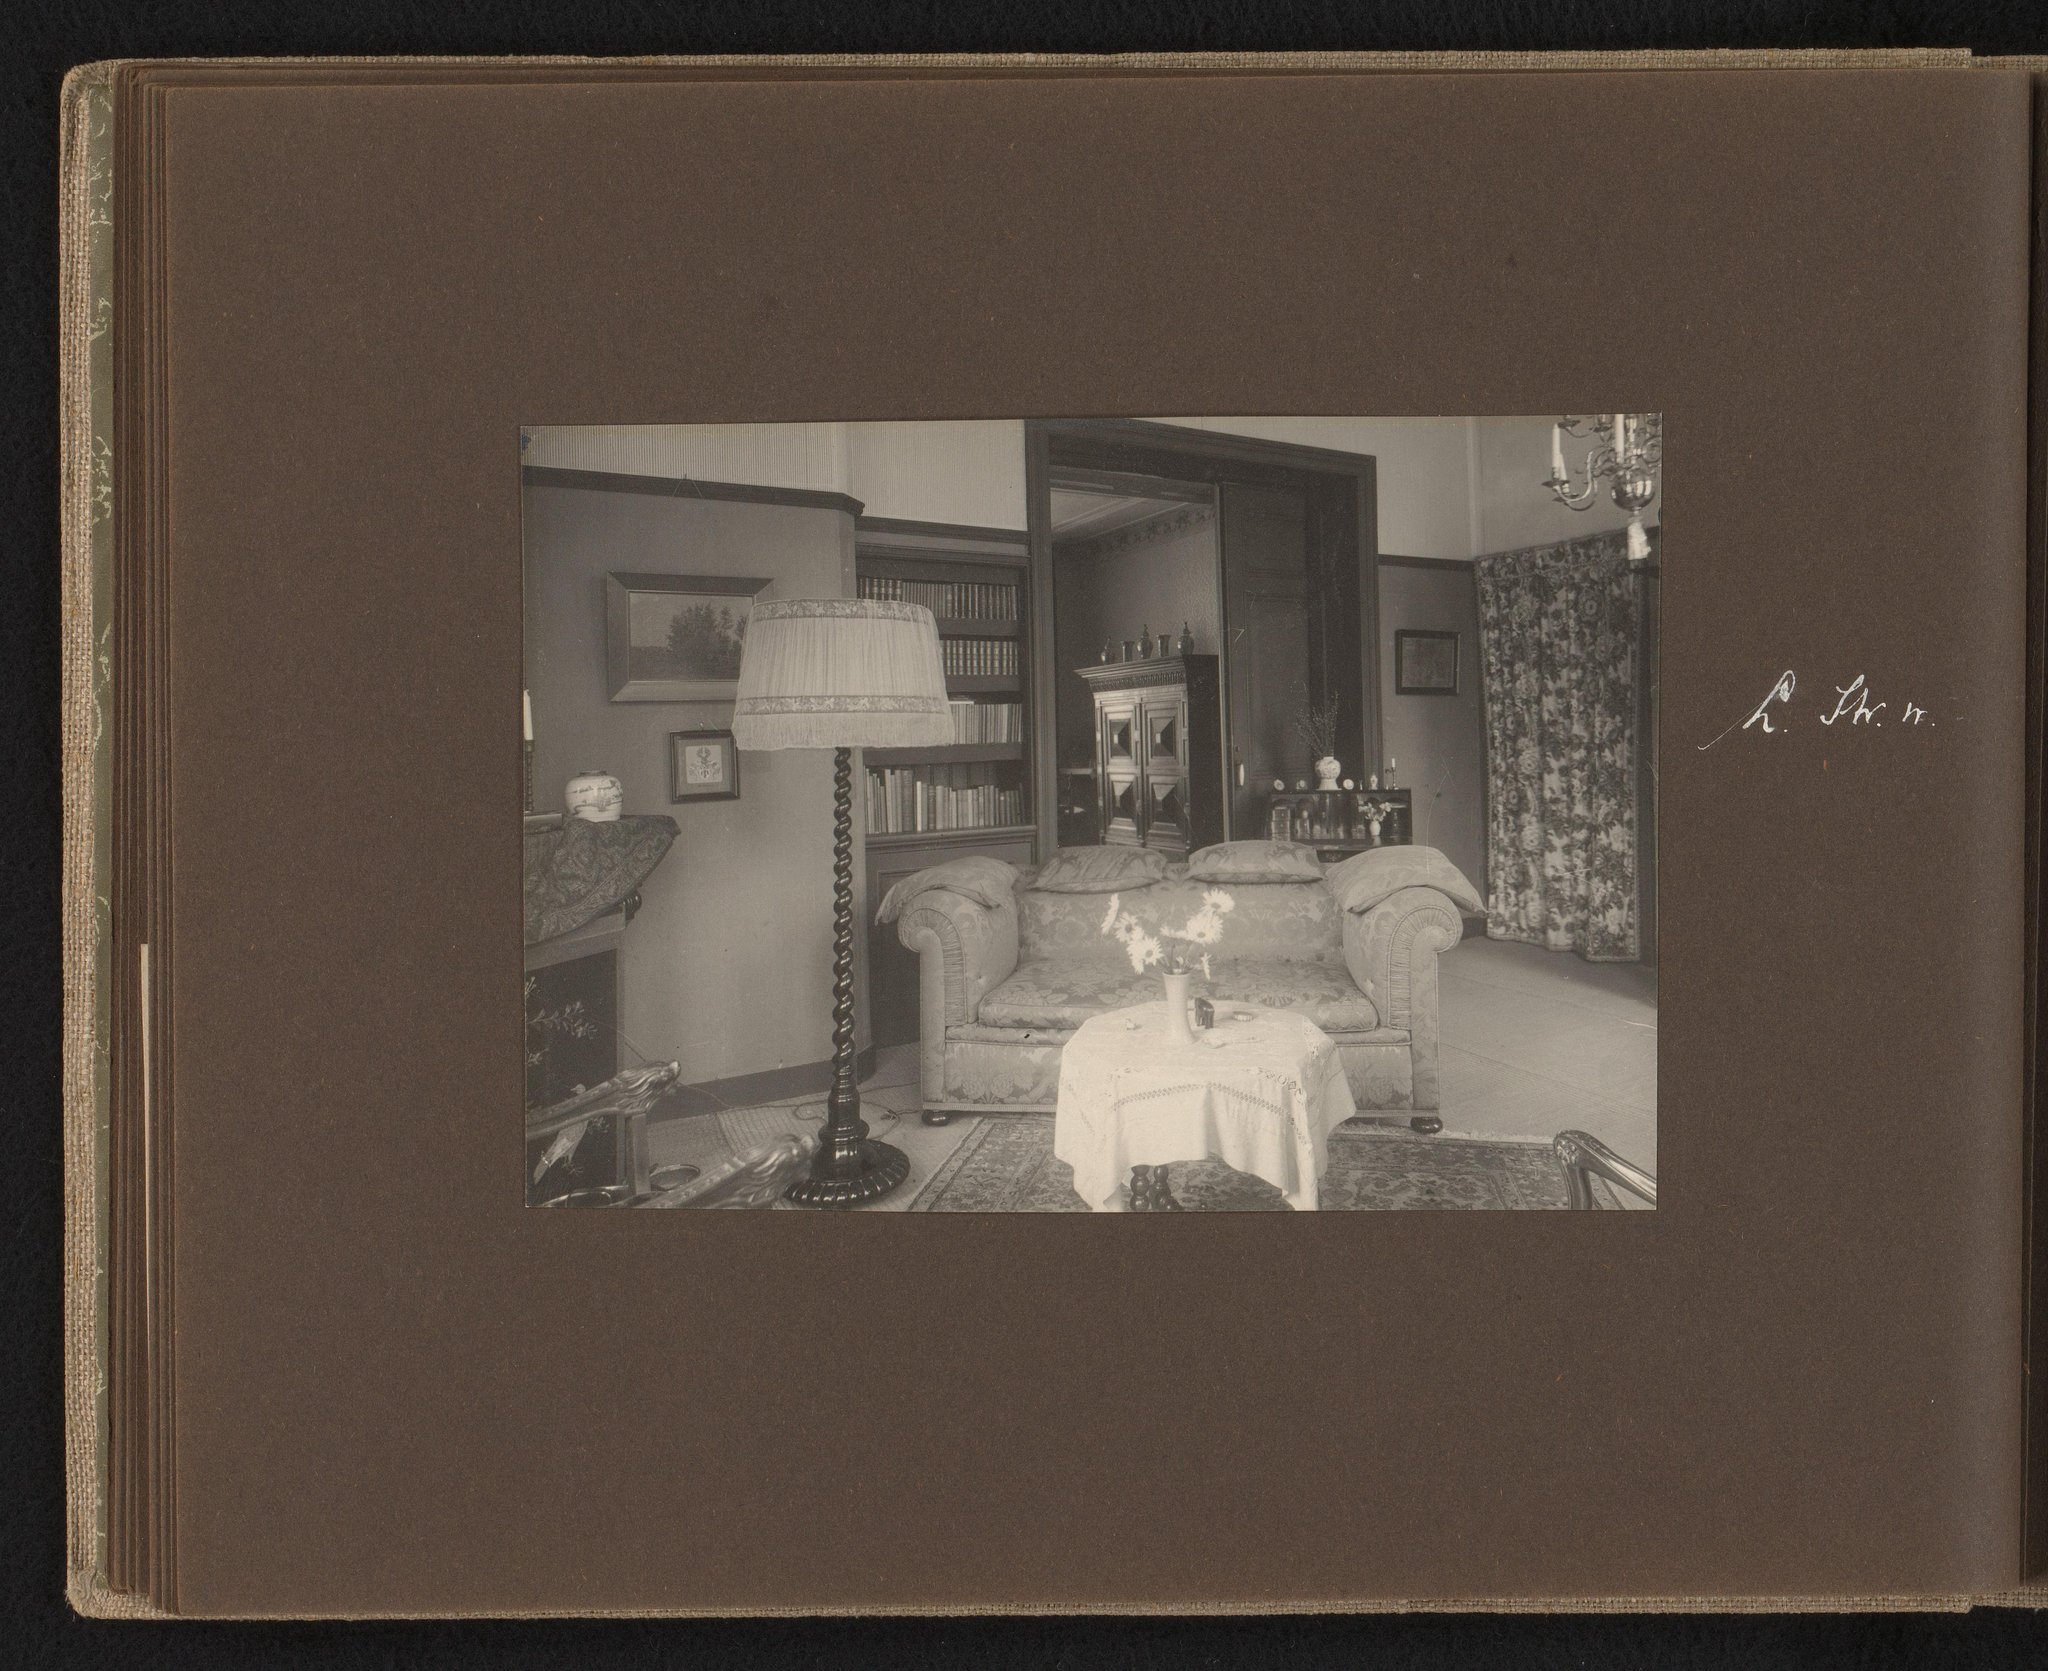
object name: photograph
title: Interieur van de woning van Johanna (Hans) de Jong en Frederik (Frits) Stokhuyzen op de Leidsestraatweg 36 te Oegstgeest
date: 1919-1930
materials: paper, cardboard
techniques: gelatin silver print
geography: oegstgeest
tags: interior of the house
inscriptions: date: ‘L. Jw. n. 36’